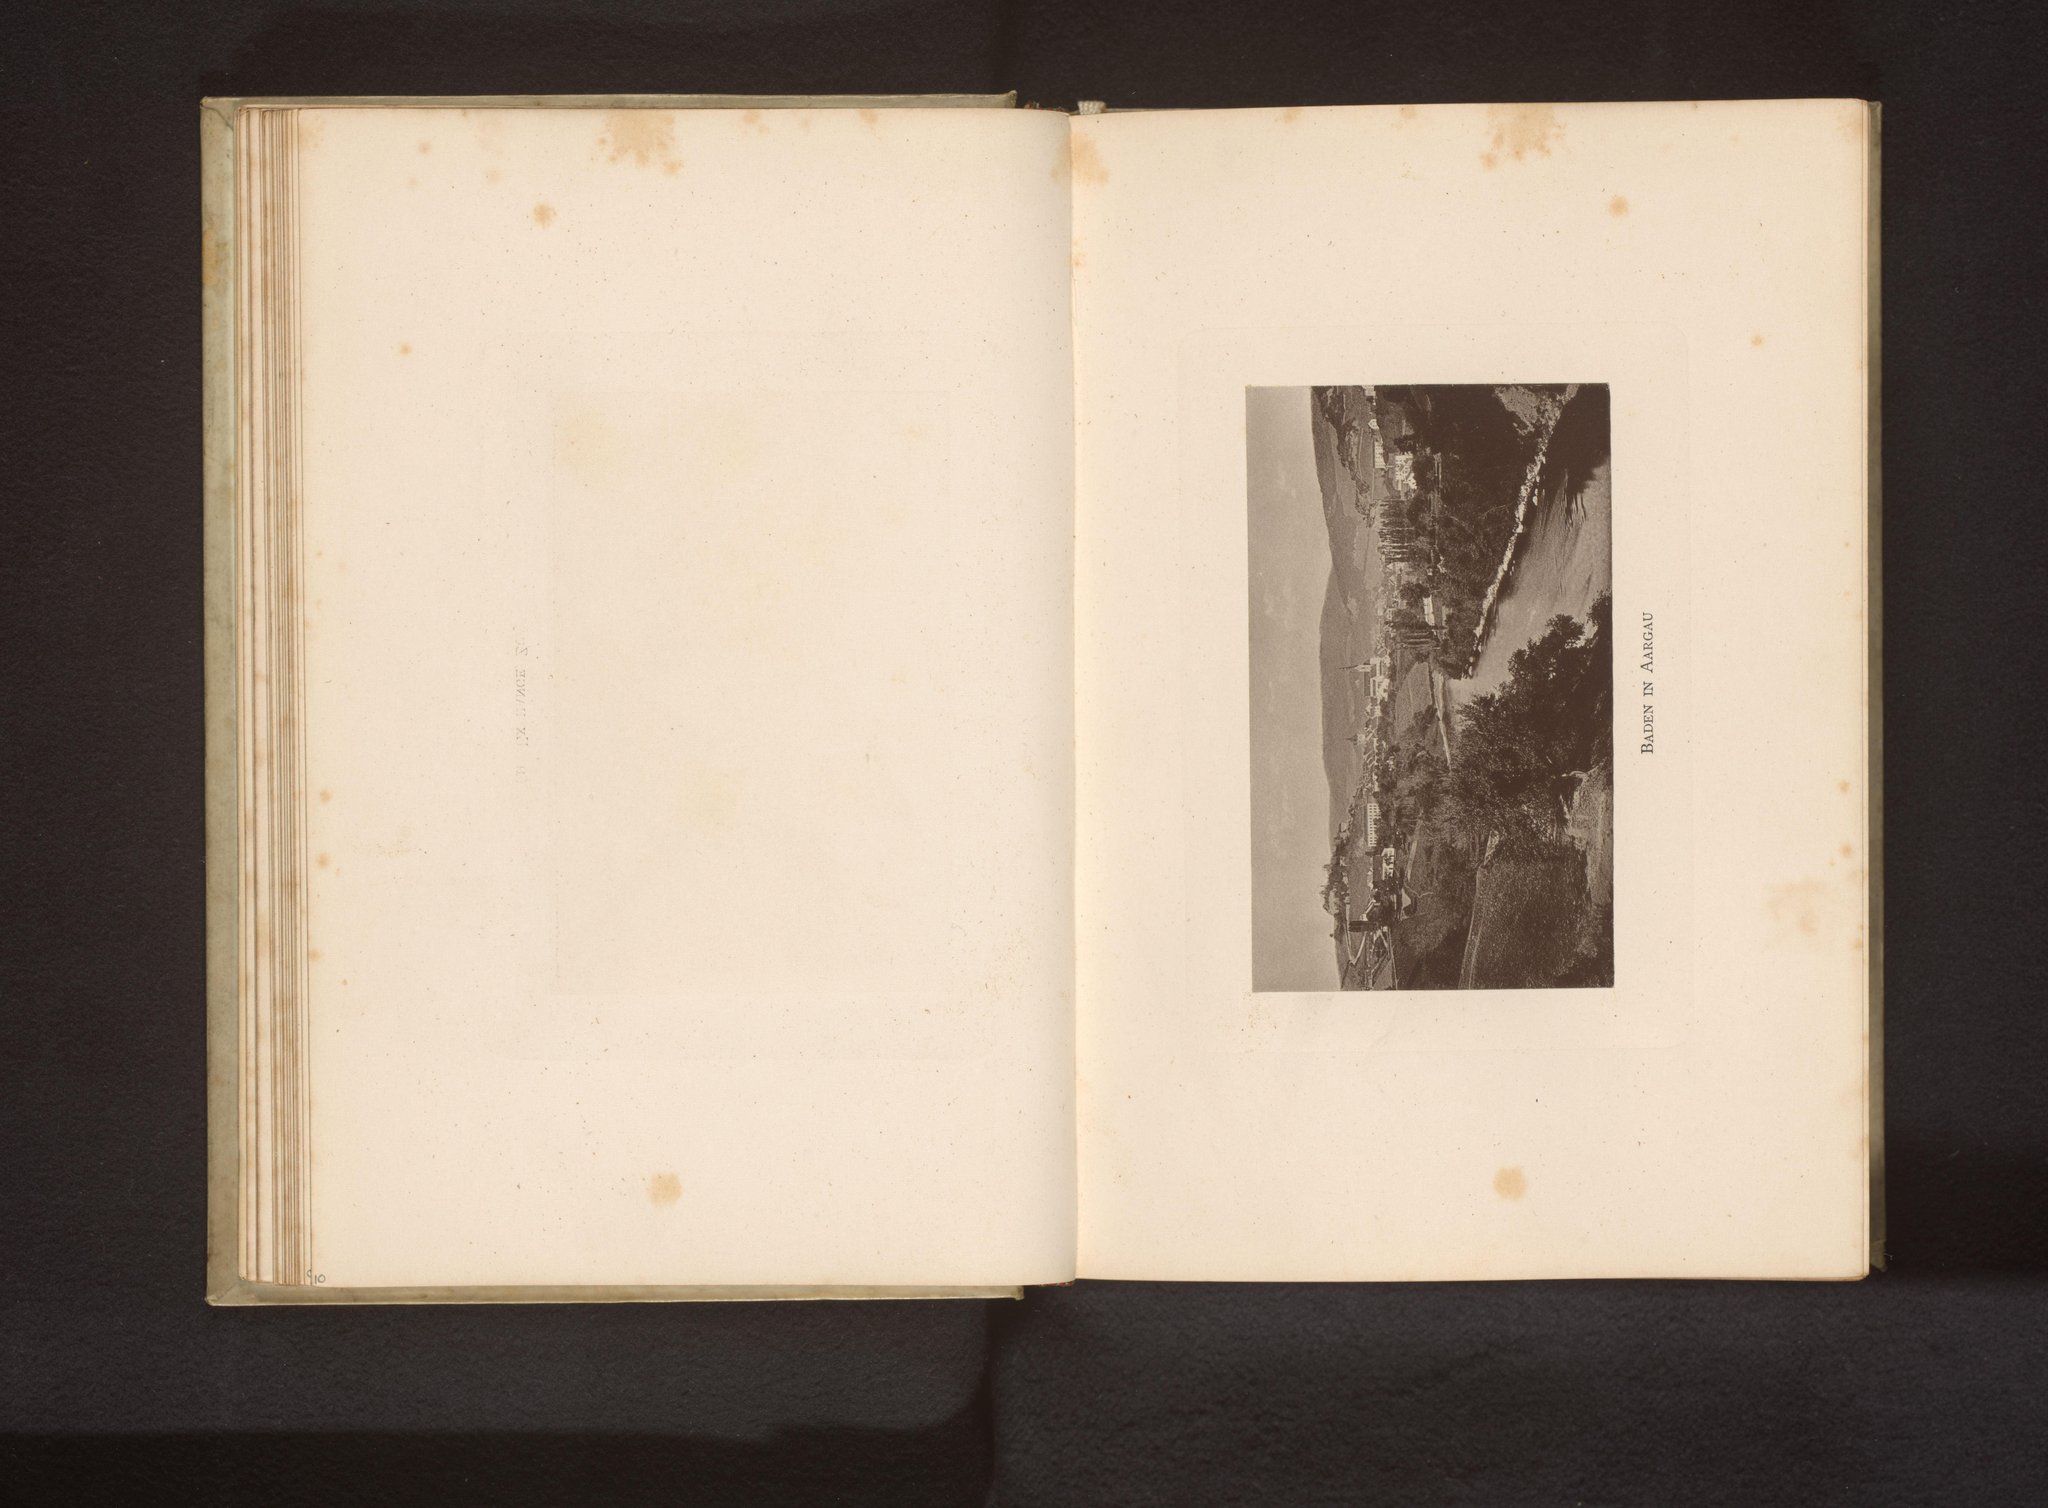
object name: page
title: Gezicht op Baden over de rivier de Limmat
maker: Anonymous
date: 1874-1884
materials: paper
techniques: photograph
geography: switzerland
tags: city-view in general; 'veduta', river